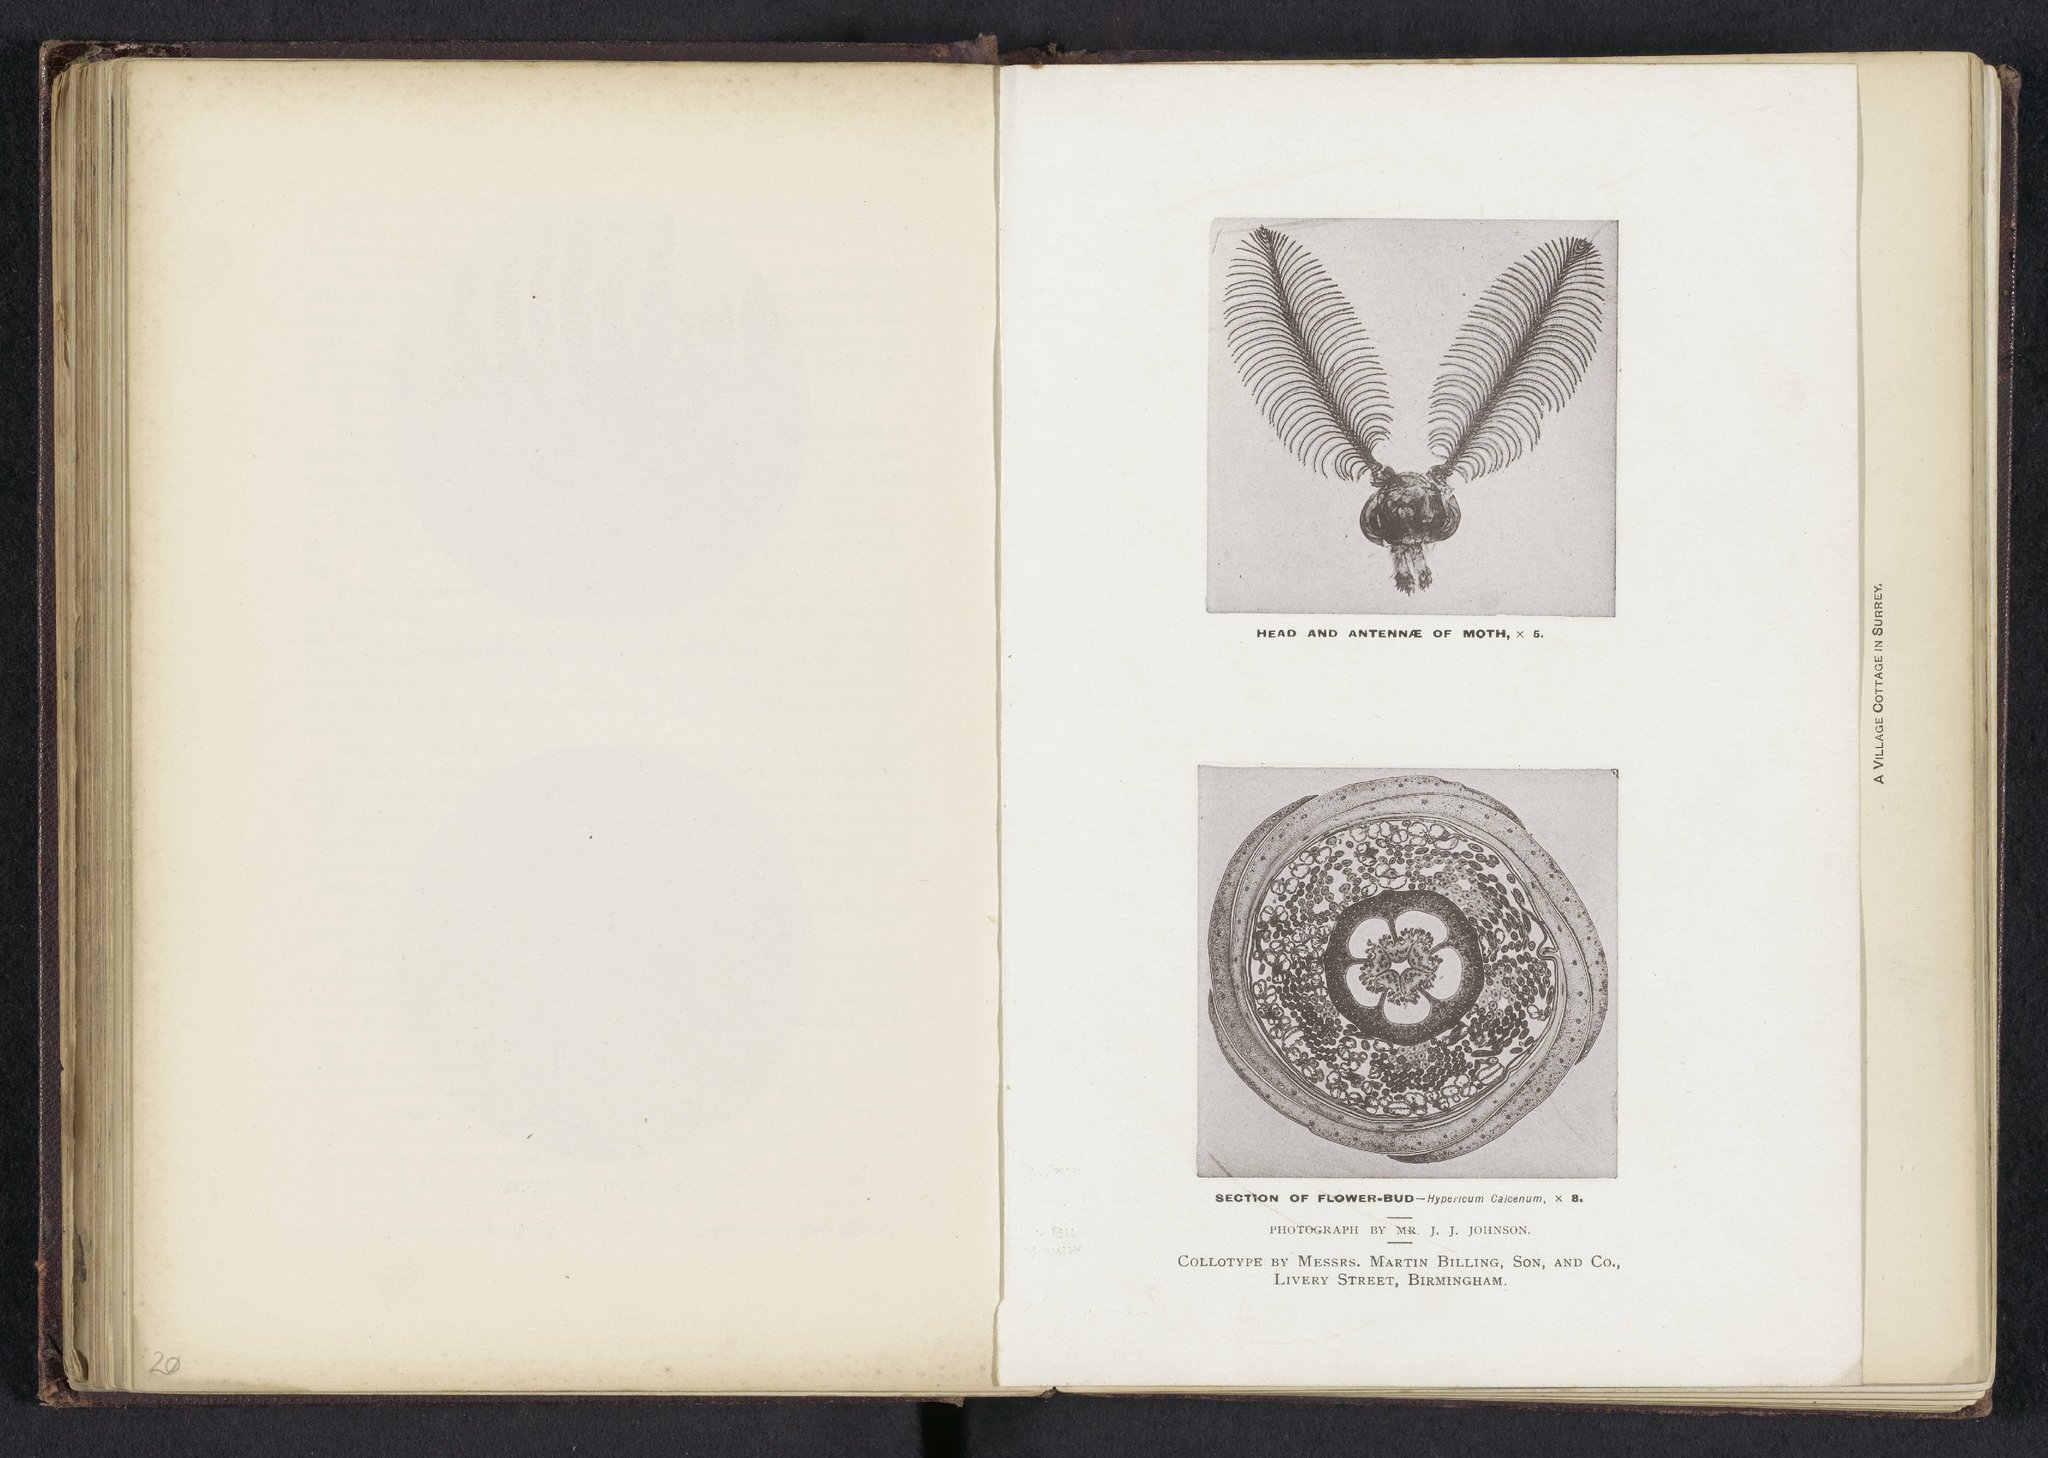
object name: photomechanical print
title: Section of flower-bud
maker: j.j. johnson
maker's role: fotograaf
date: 1889-1899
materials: paper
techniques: photograph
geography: london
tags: insects: moth (+ antlers; horn), flowers (+ parts of plants)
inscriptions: inscription: ‘x 5. x 8.’